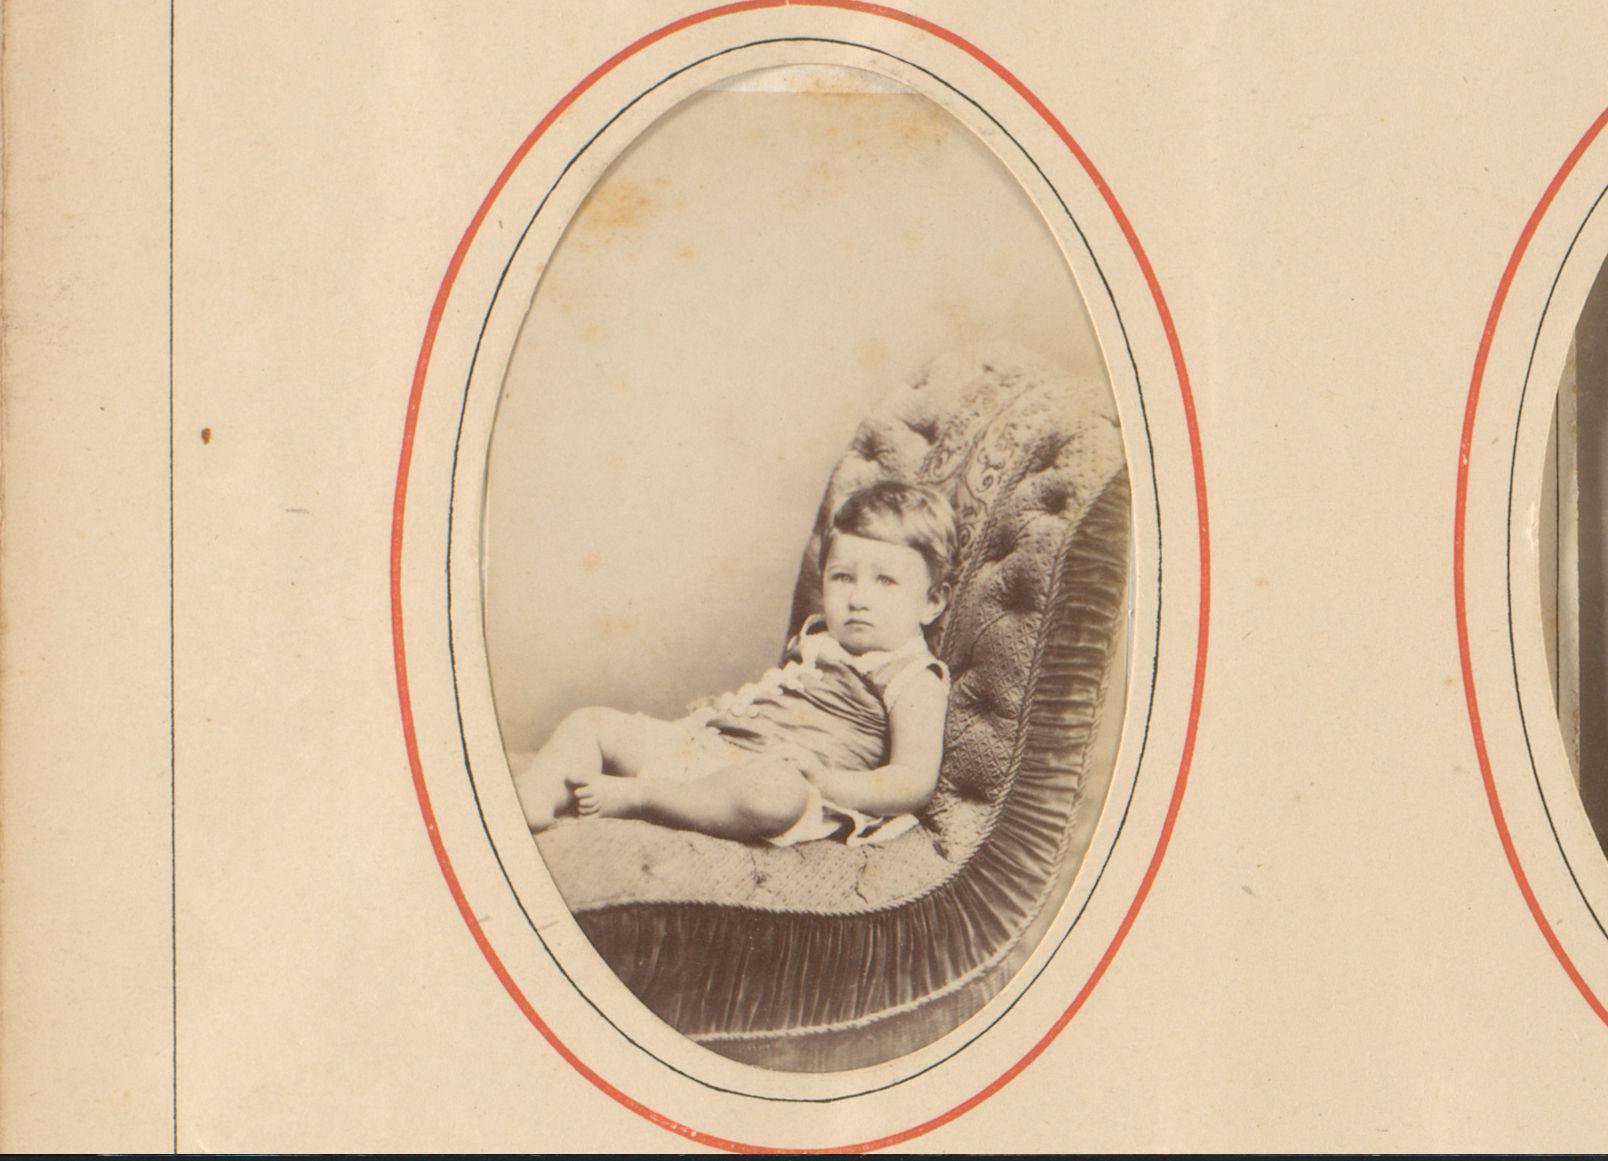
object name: carte de visite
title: Portret van een onbekend kind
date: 1871-1890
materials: cardboard, paper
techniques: albumen print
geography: batavia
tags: anonymous historical person portrayed